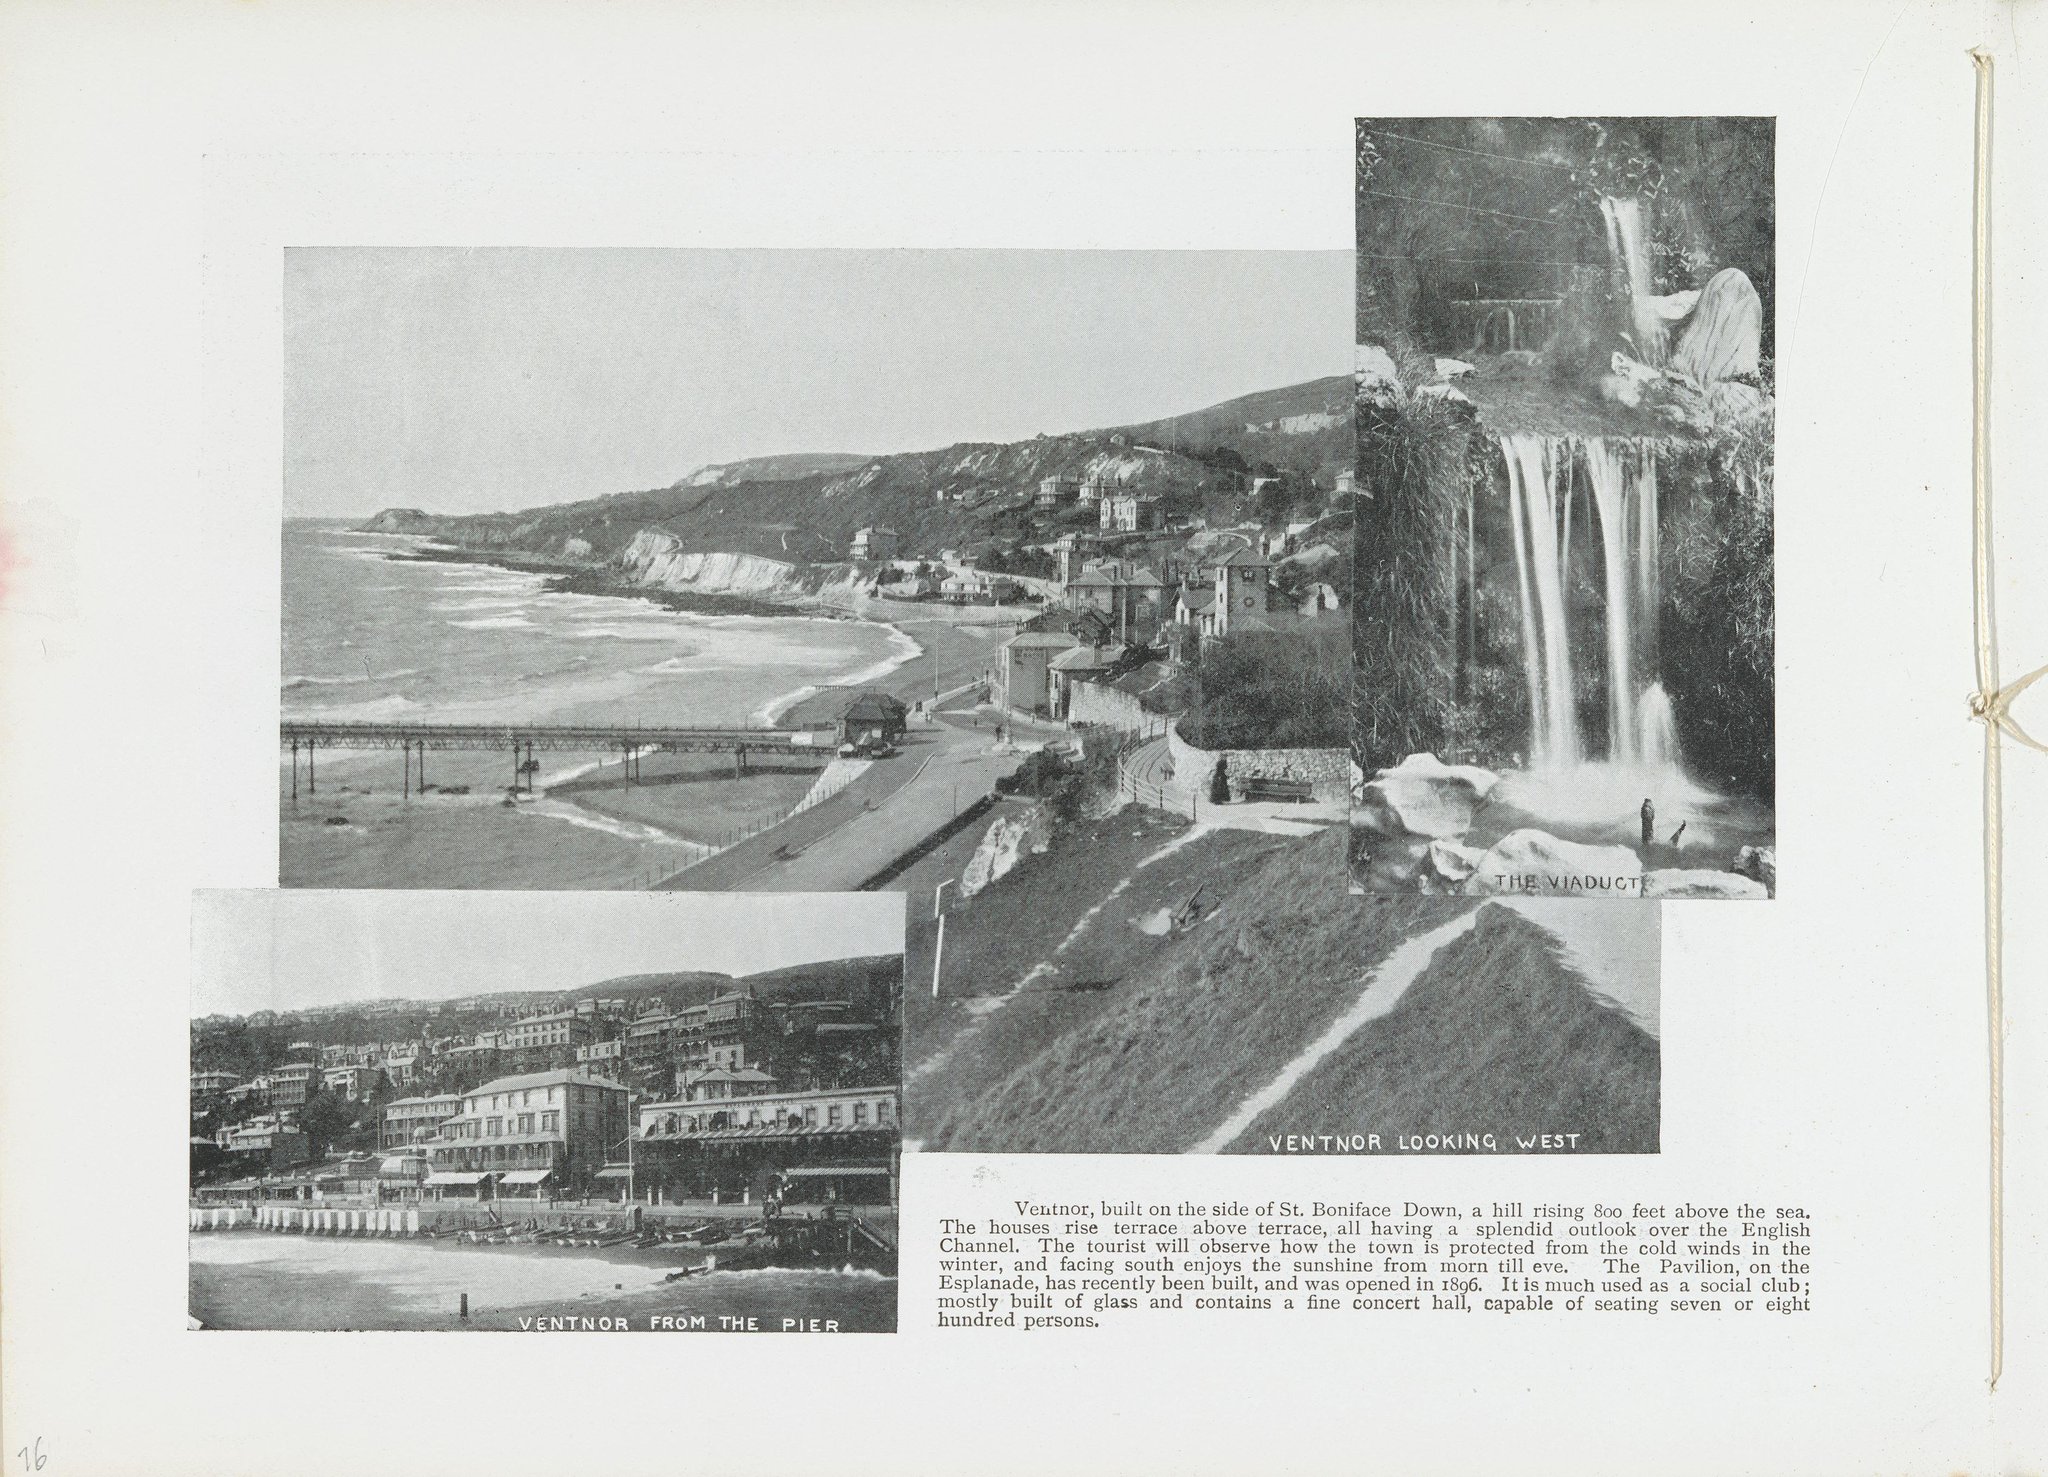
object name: photograph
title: Ventnor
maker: Anonymous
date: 1897-1930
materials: paper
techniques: printing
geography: isle of wight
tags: beach (as place of recreation), waterfall, travelling; tourism, coastal cliff or crag, isle of wight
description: Pagina 16 met 3 foto's van het strand, de kliffen en een waterval (The Viaduct) in Ventnor en een bijschrift. Onderdeel van Fotografische reisreportage van het eiland Wight.